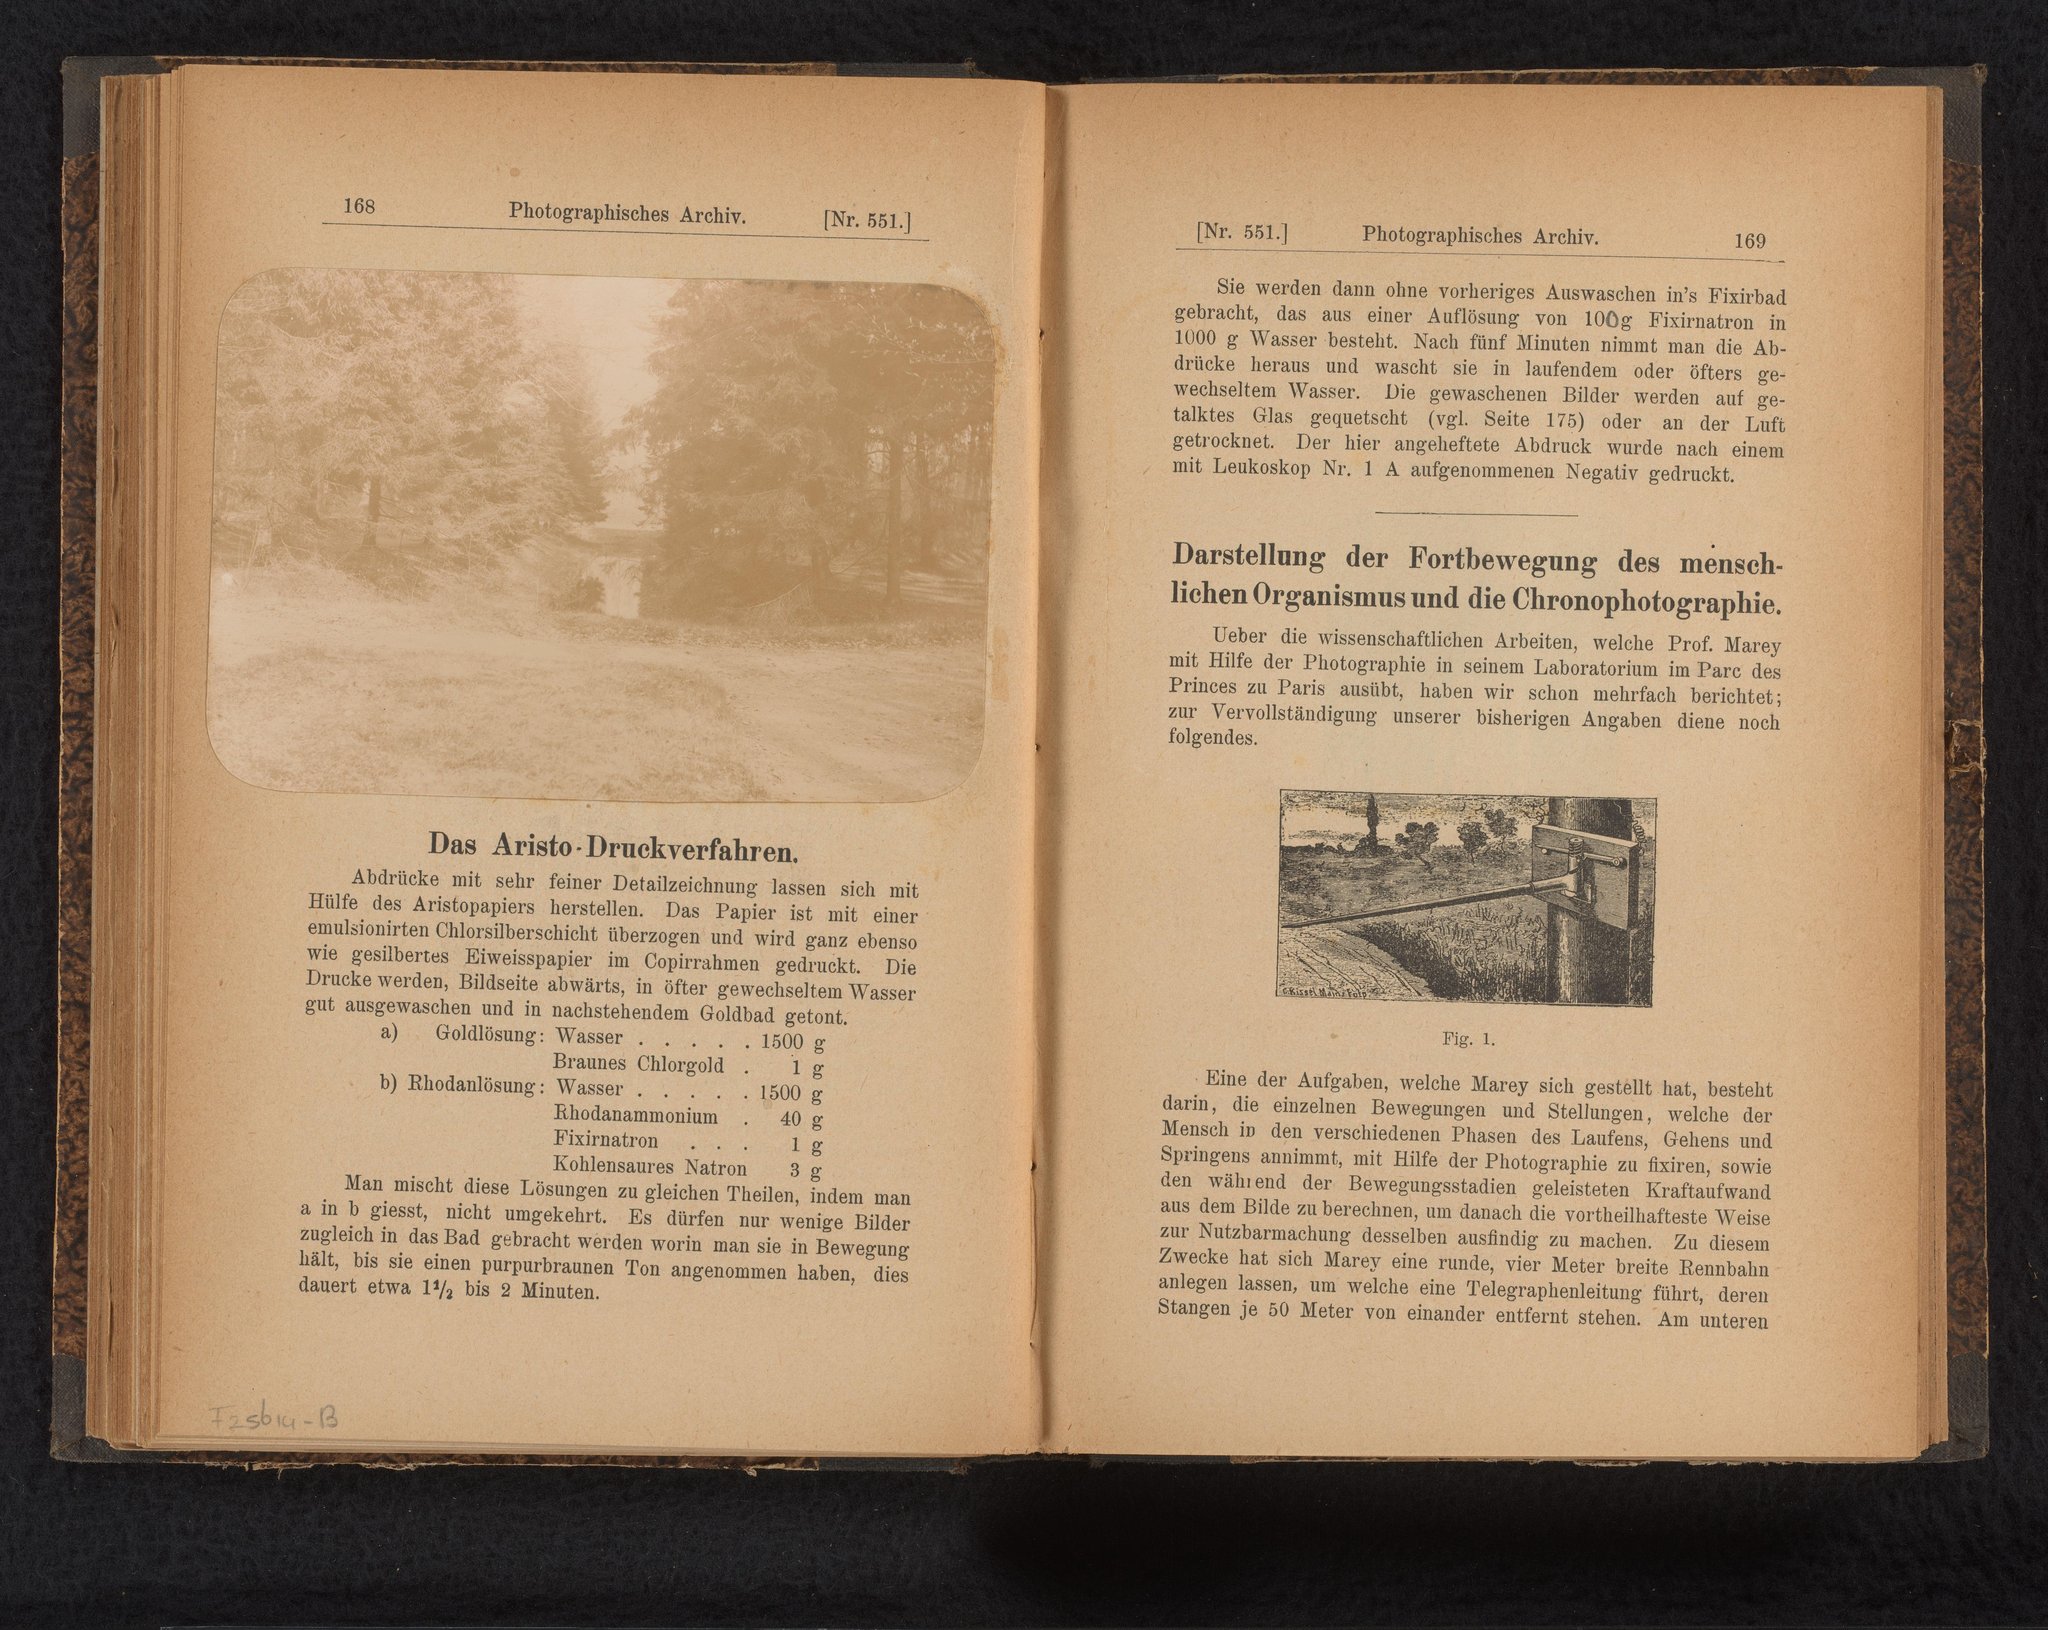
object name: photograph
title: Bosgezicht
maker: Anonymous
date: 1881-1886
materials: paper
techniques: gelatin silver print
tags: forest, wood